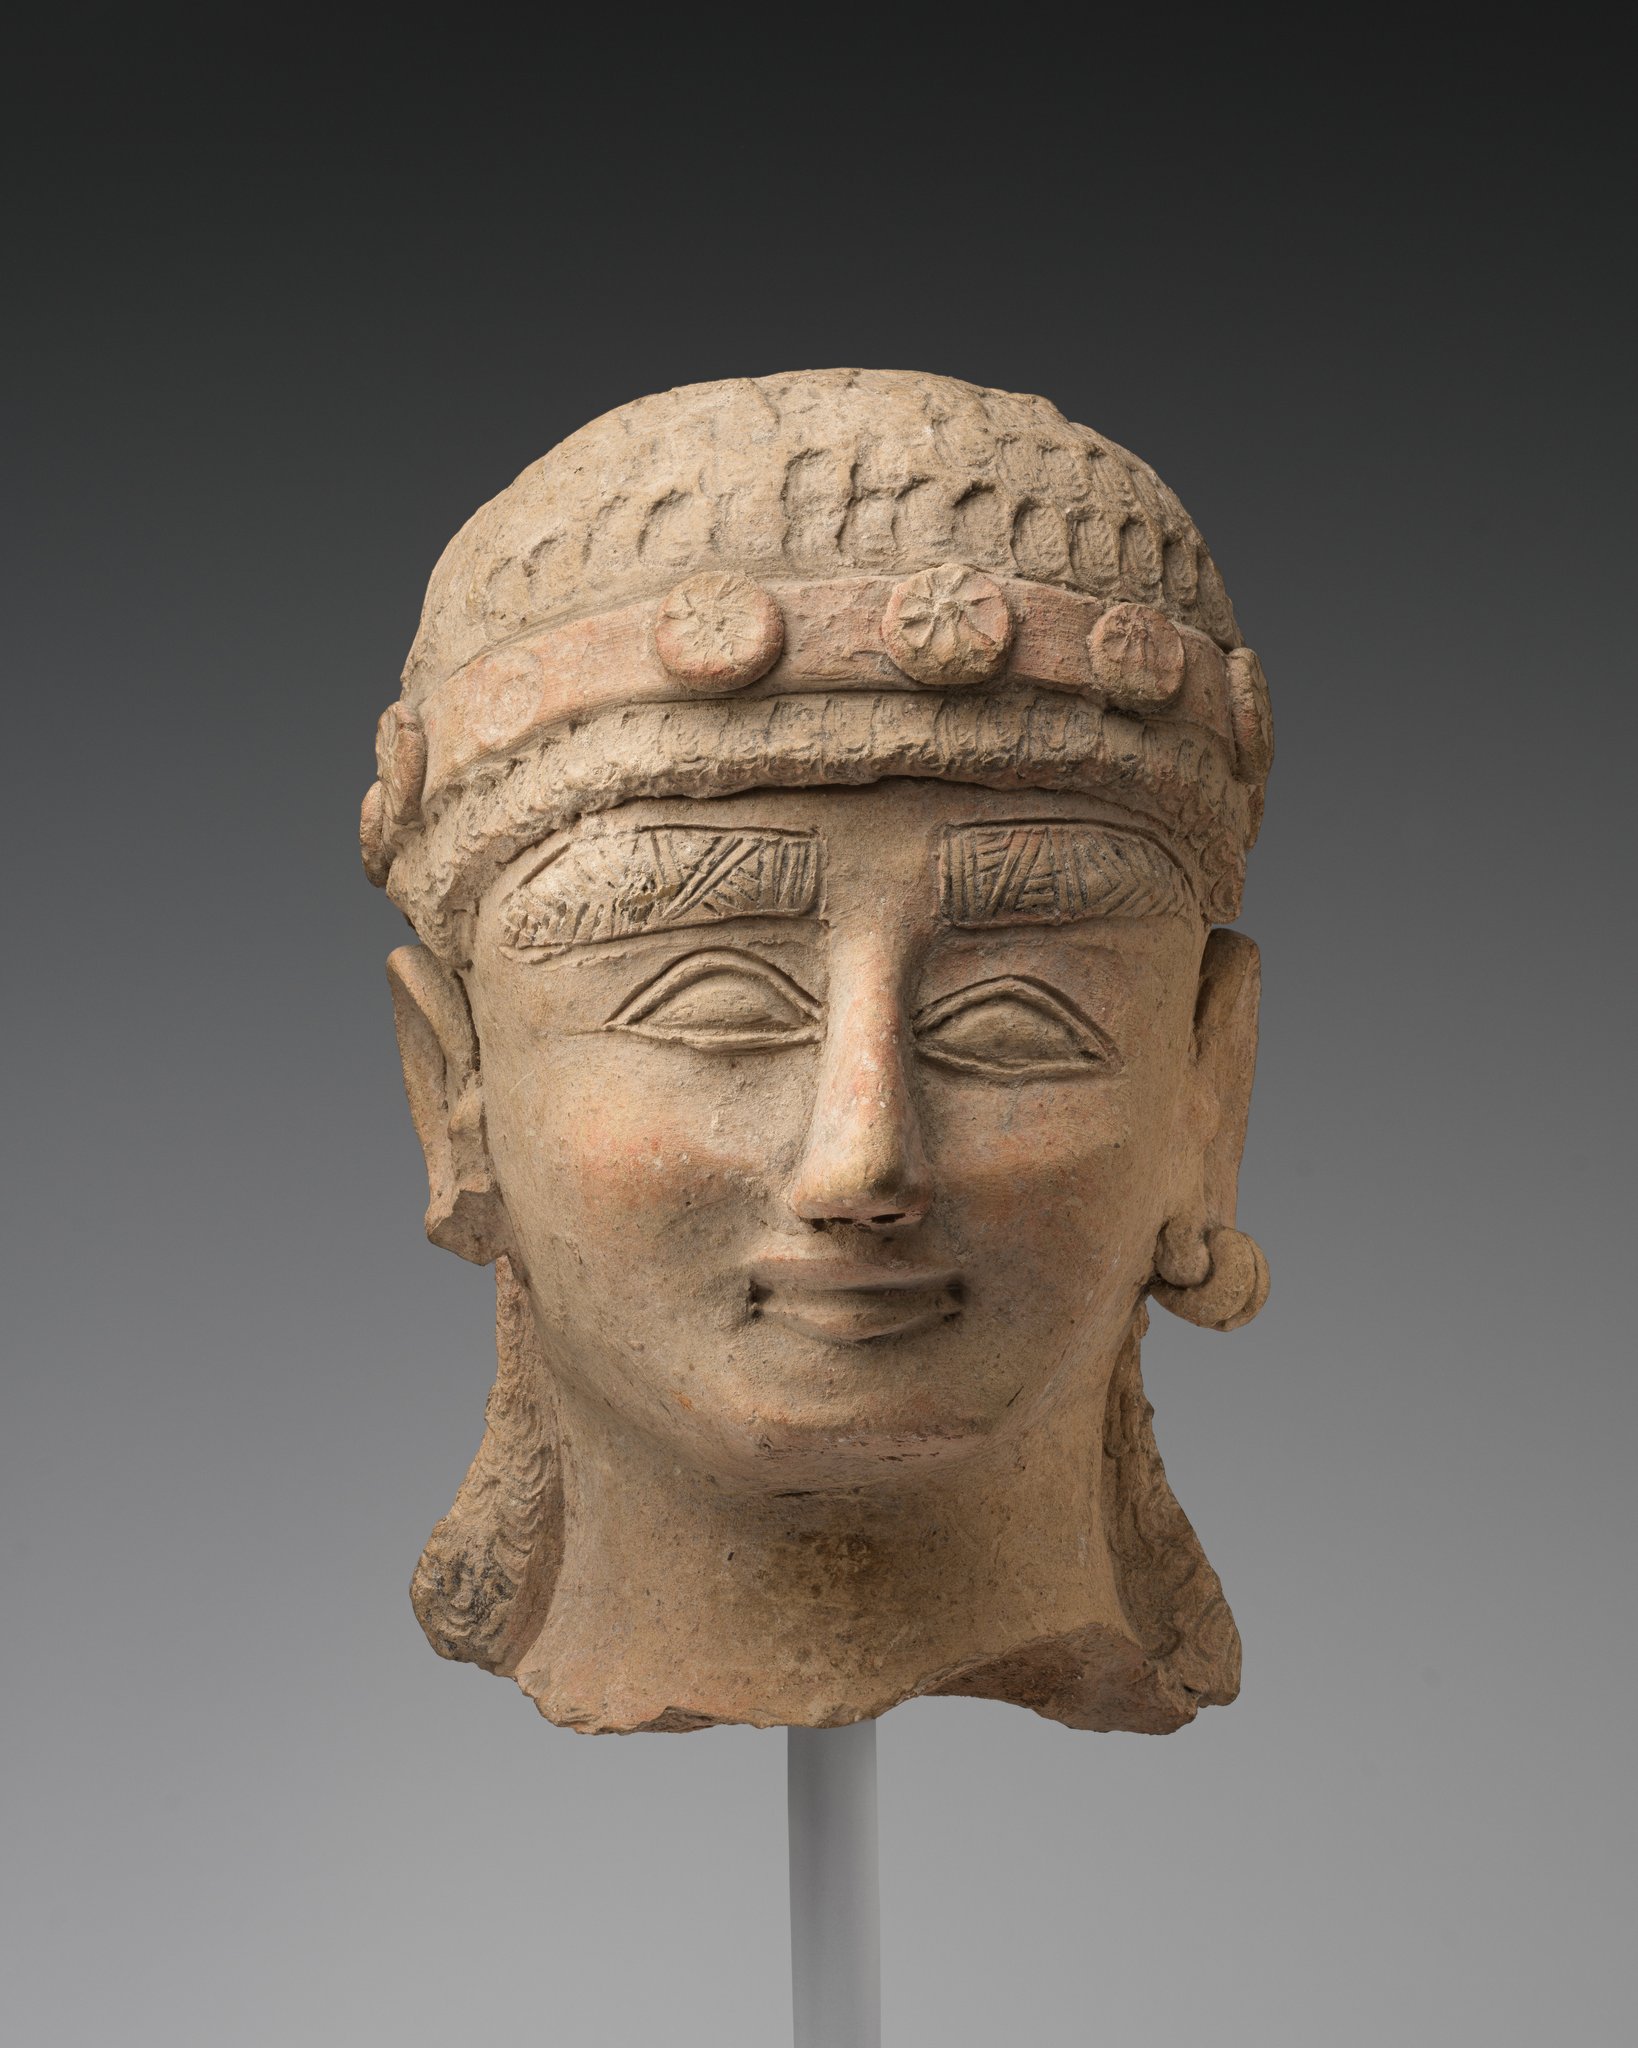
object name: head of a man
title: Terracotta head of a man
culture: cypriot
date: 600 BCE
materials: terracotta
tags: heads,men